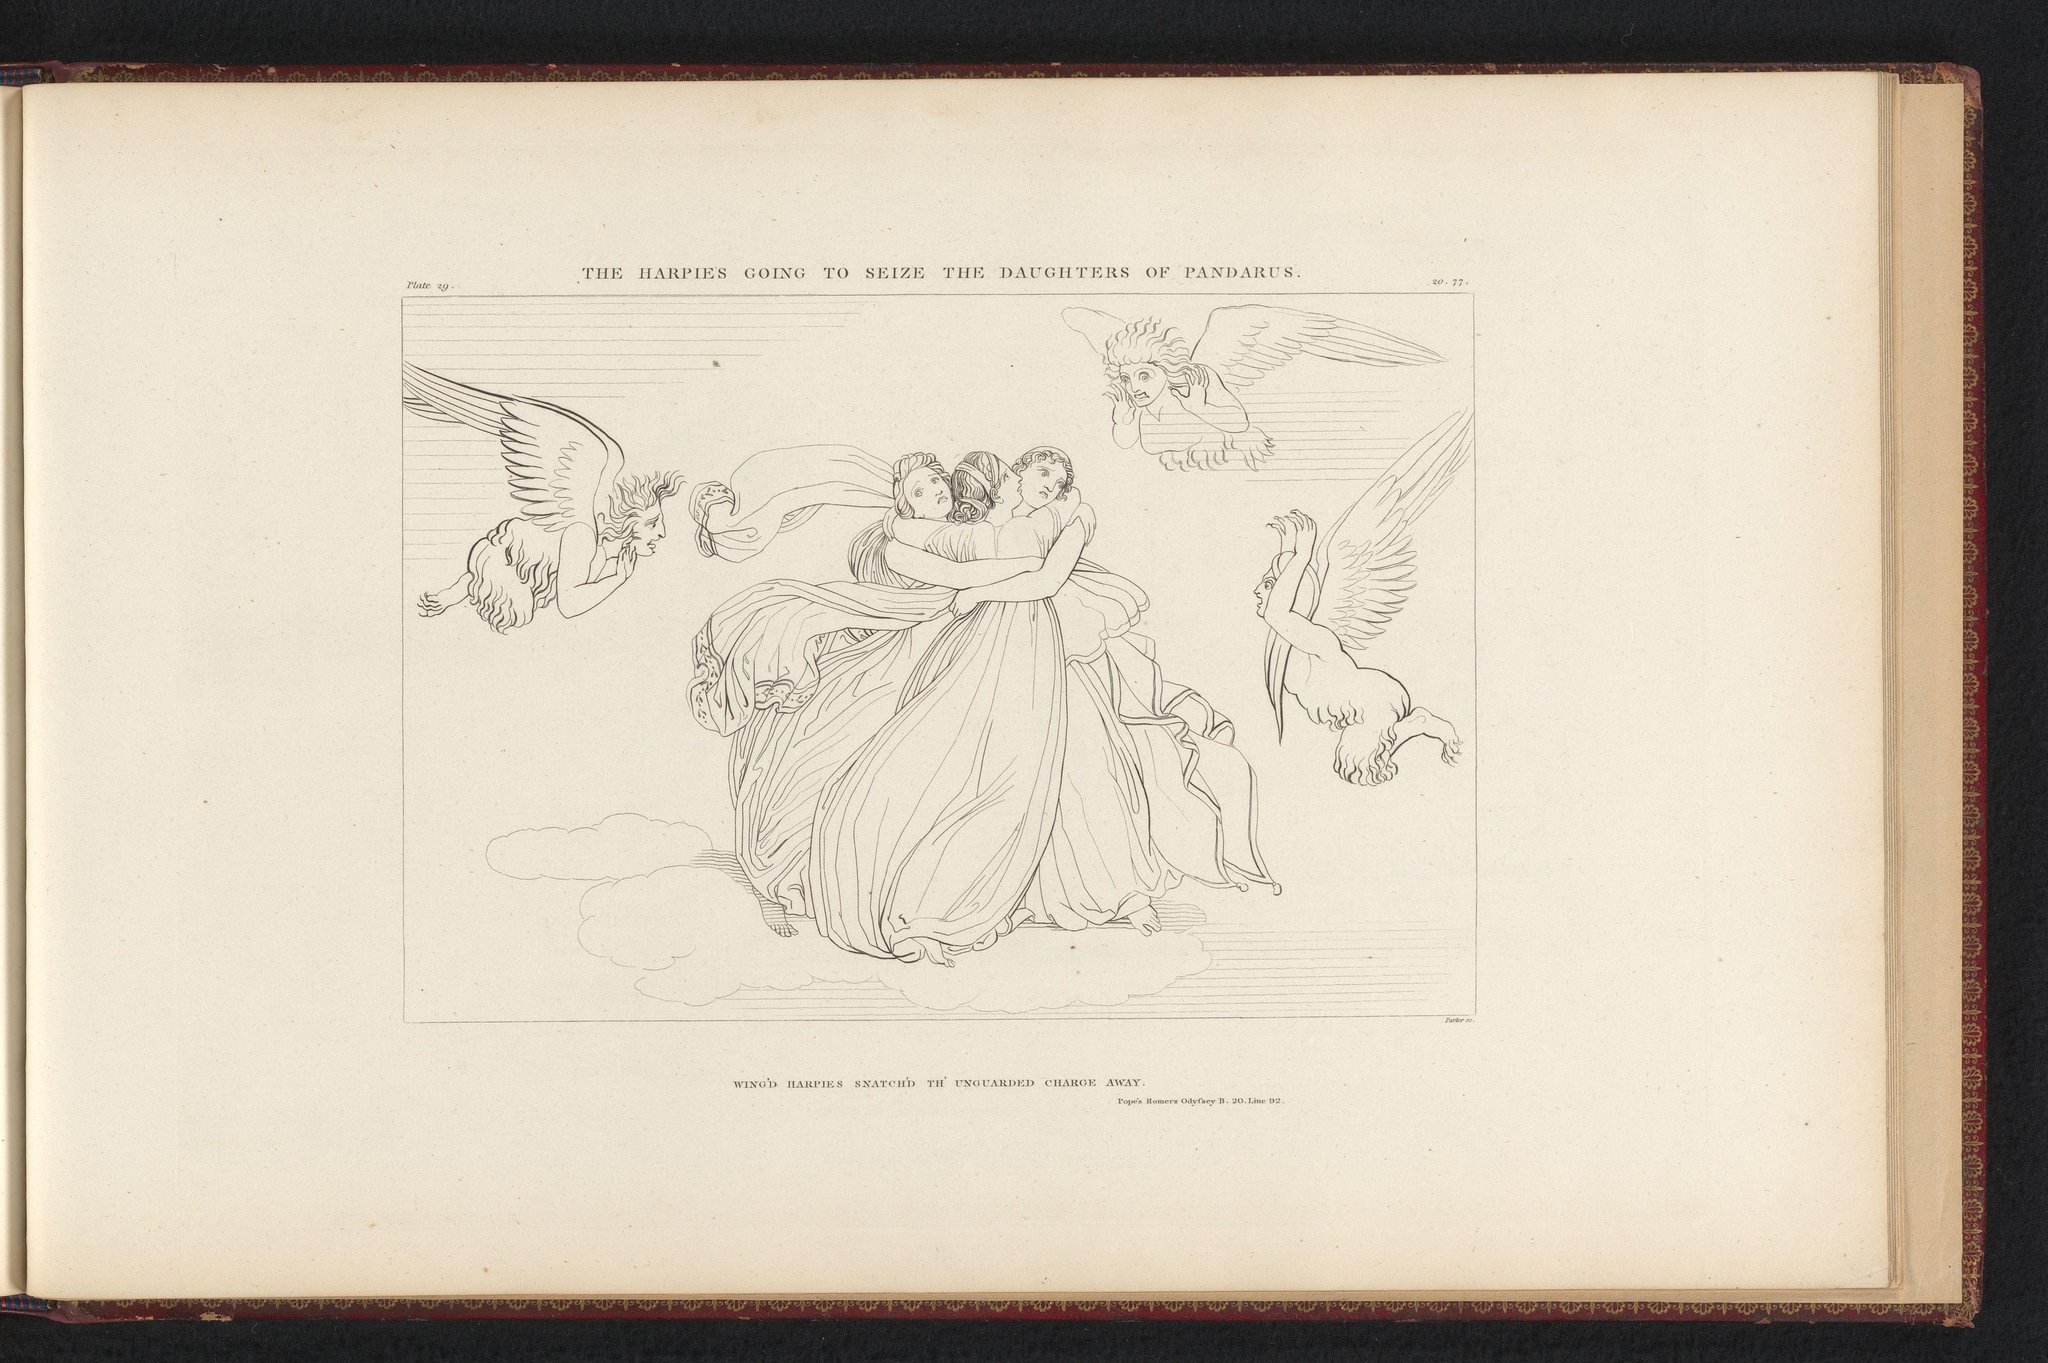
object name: album leaf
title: Odyssee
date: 1805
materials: paper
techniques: etching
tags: pandareus' daughters are carried away by the harpies and delivered to the furies as servants in hades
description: Prent maakt onderdeel uit van een serie met 34 prenten over de Odyssee, geschreven door Homerus.